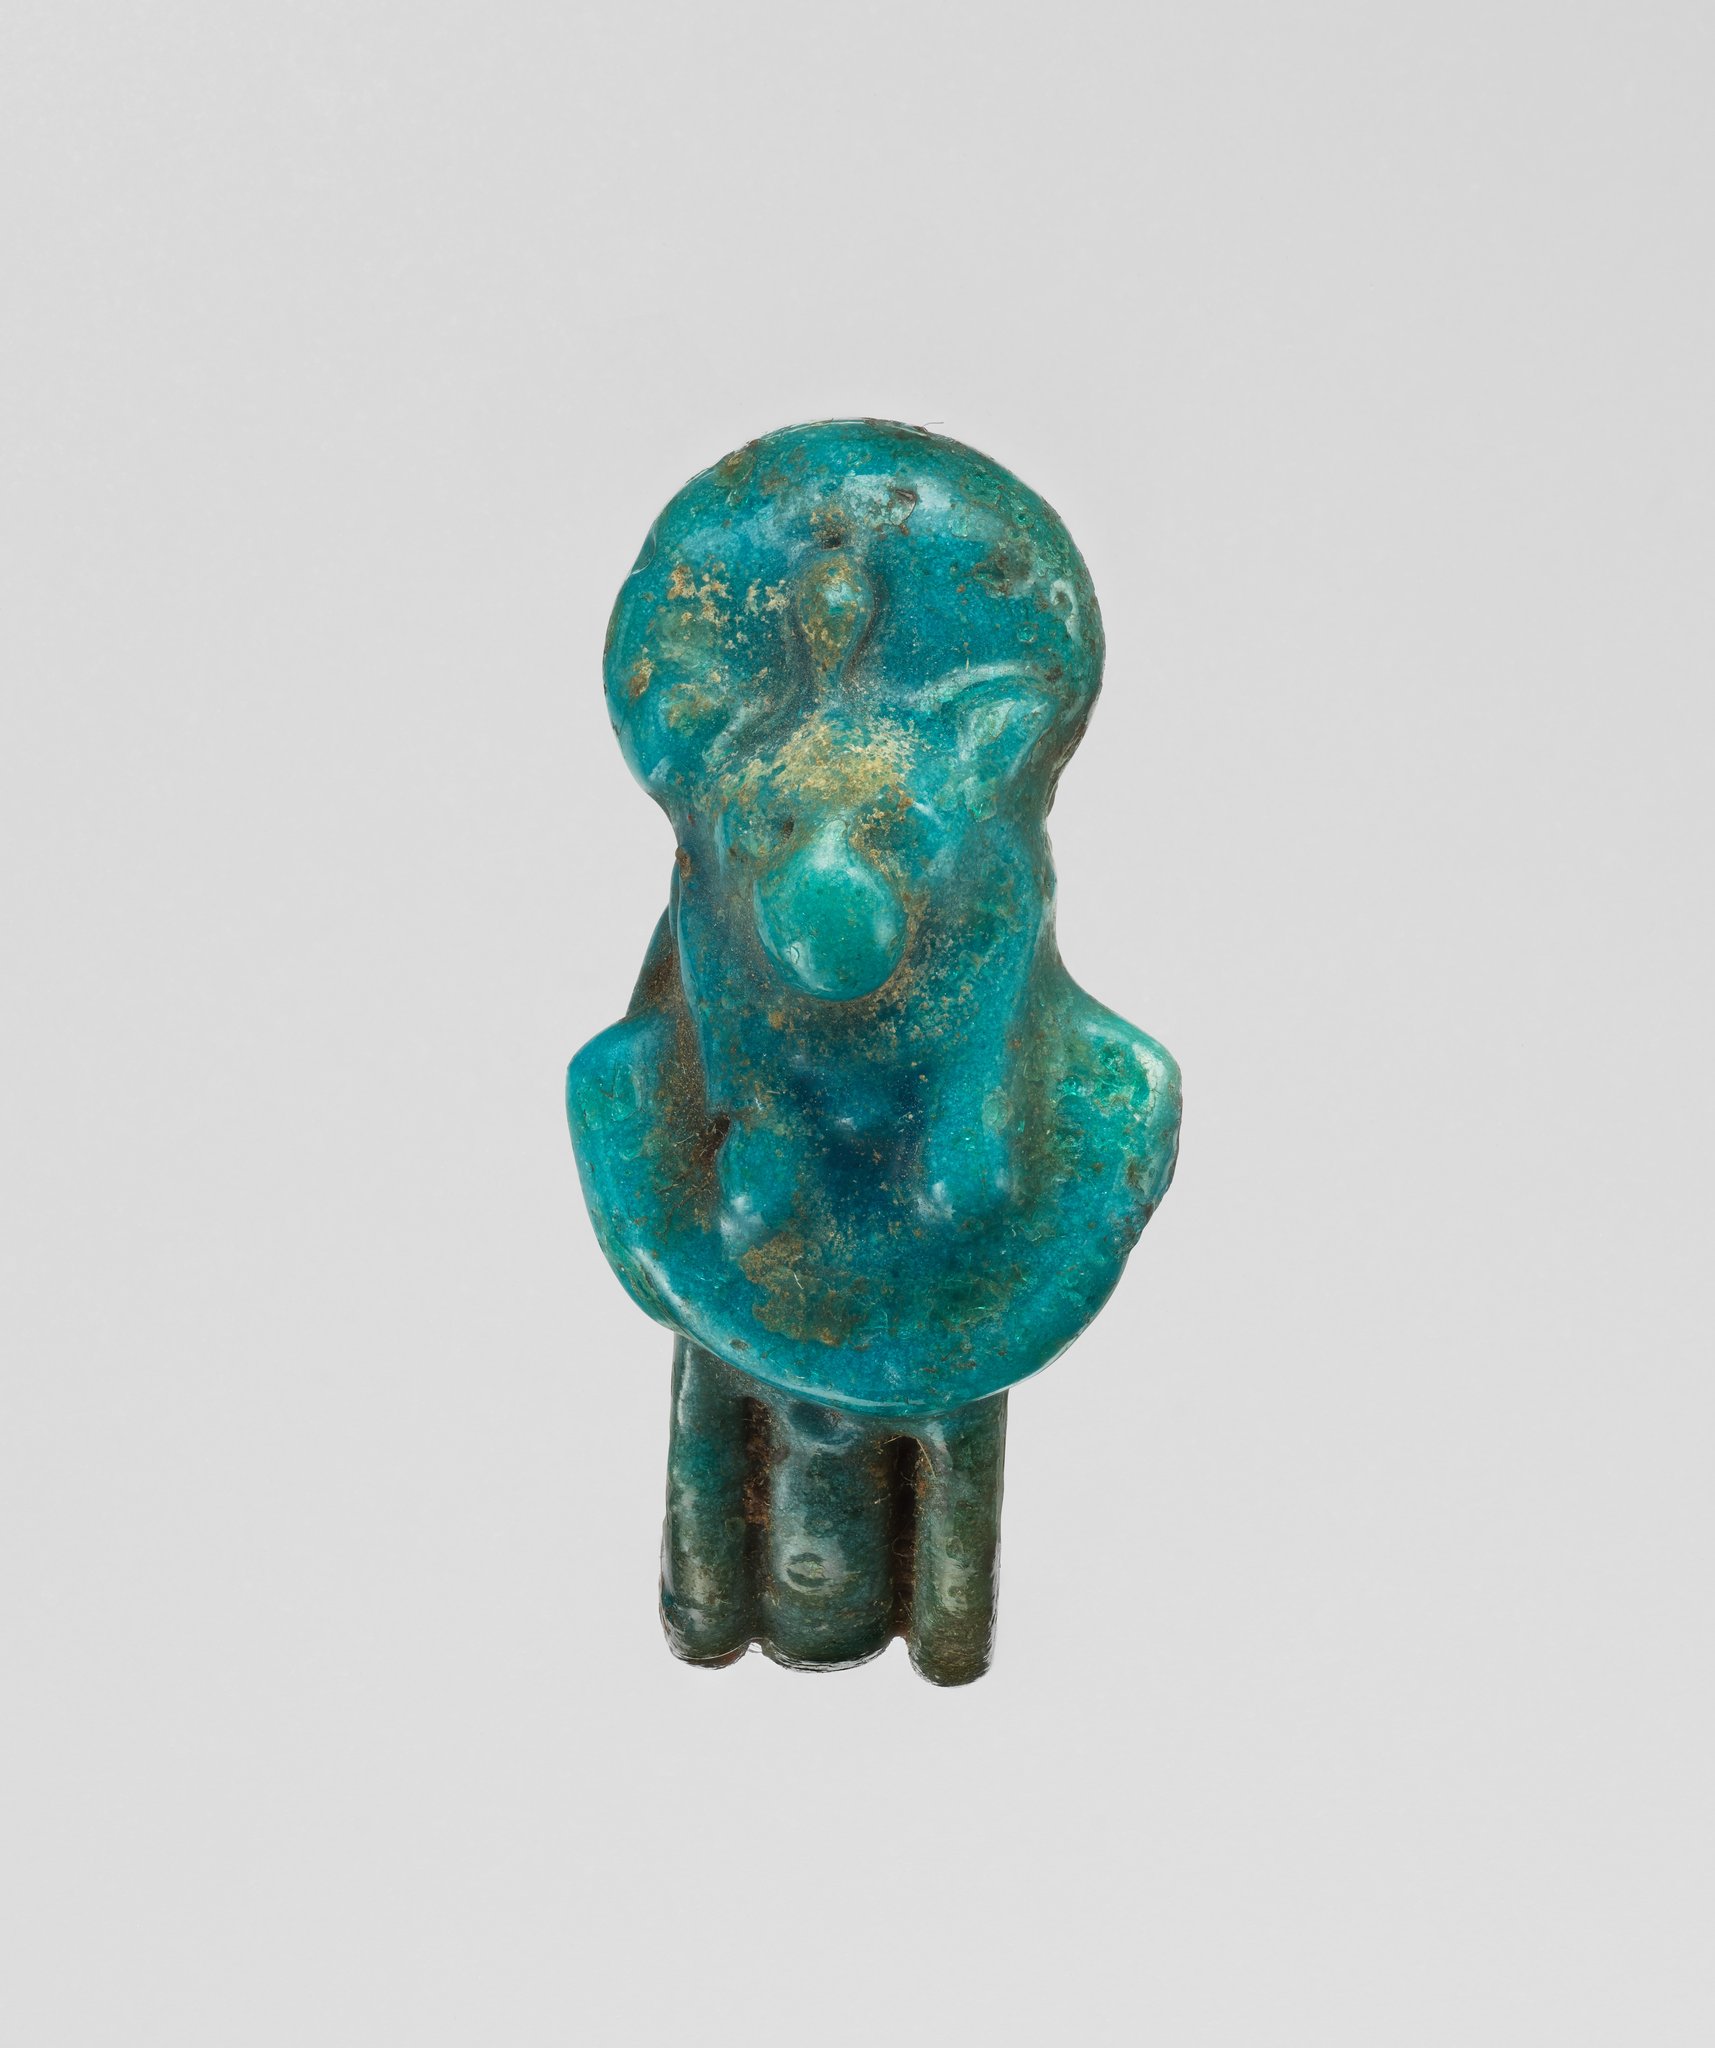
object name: ring, lioness head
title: Finger Ring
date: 1070-712 BCE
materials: faience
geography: egypt